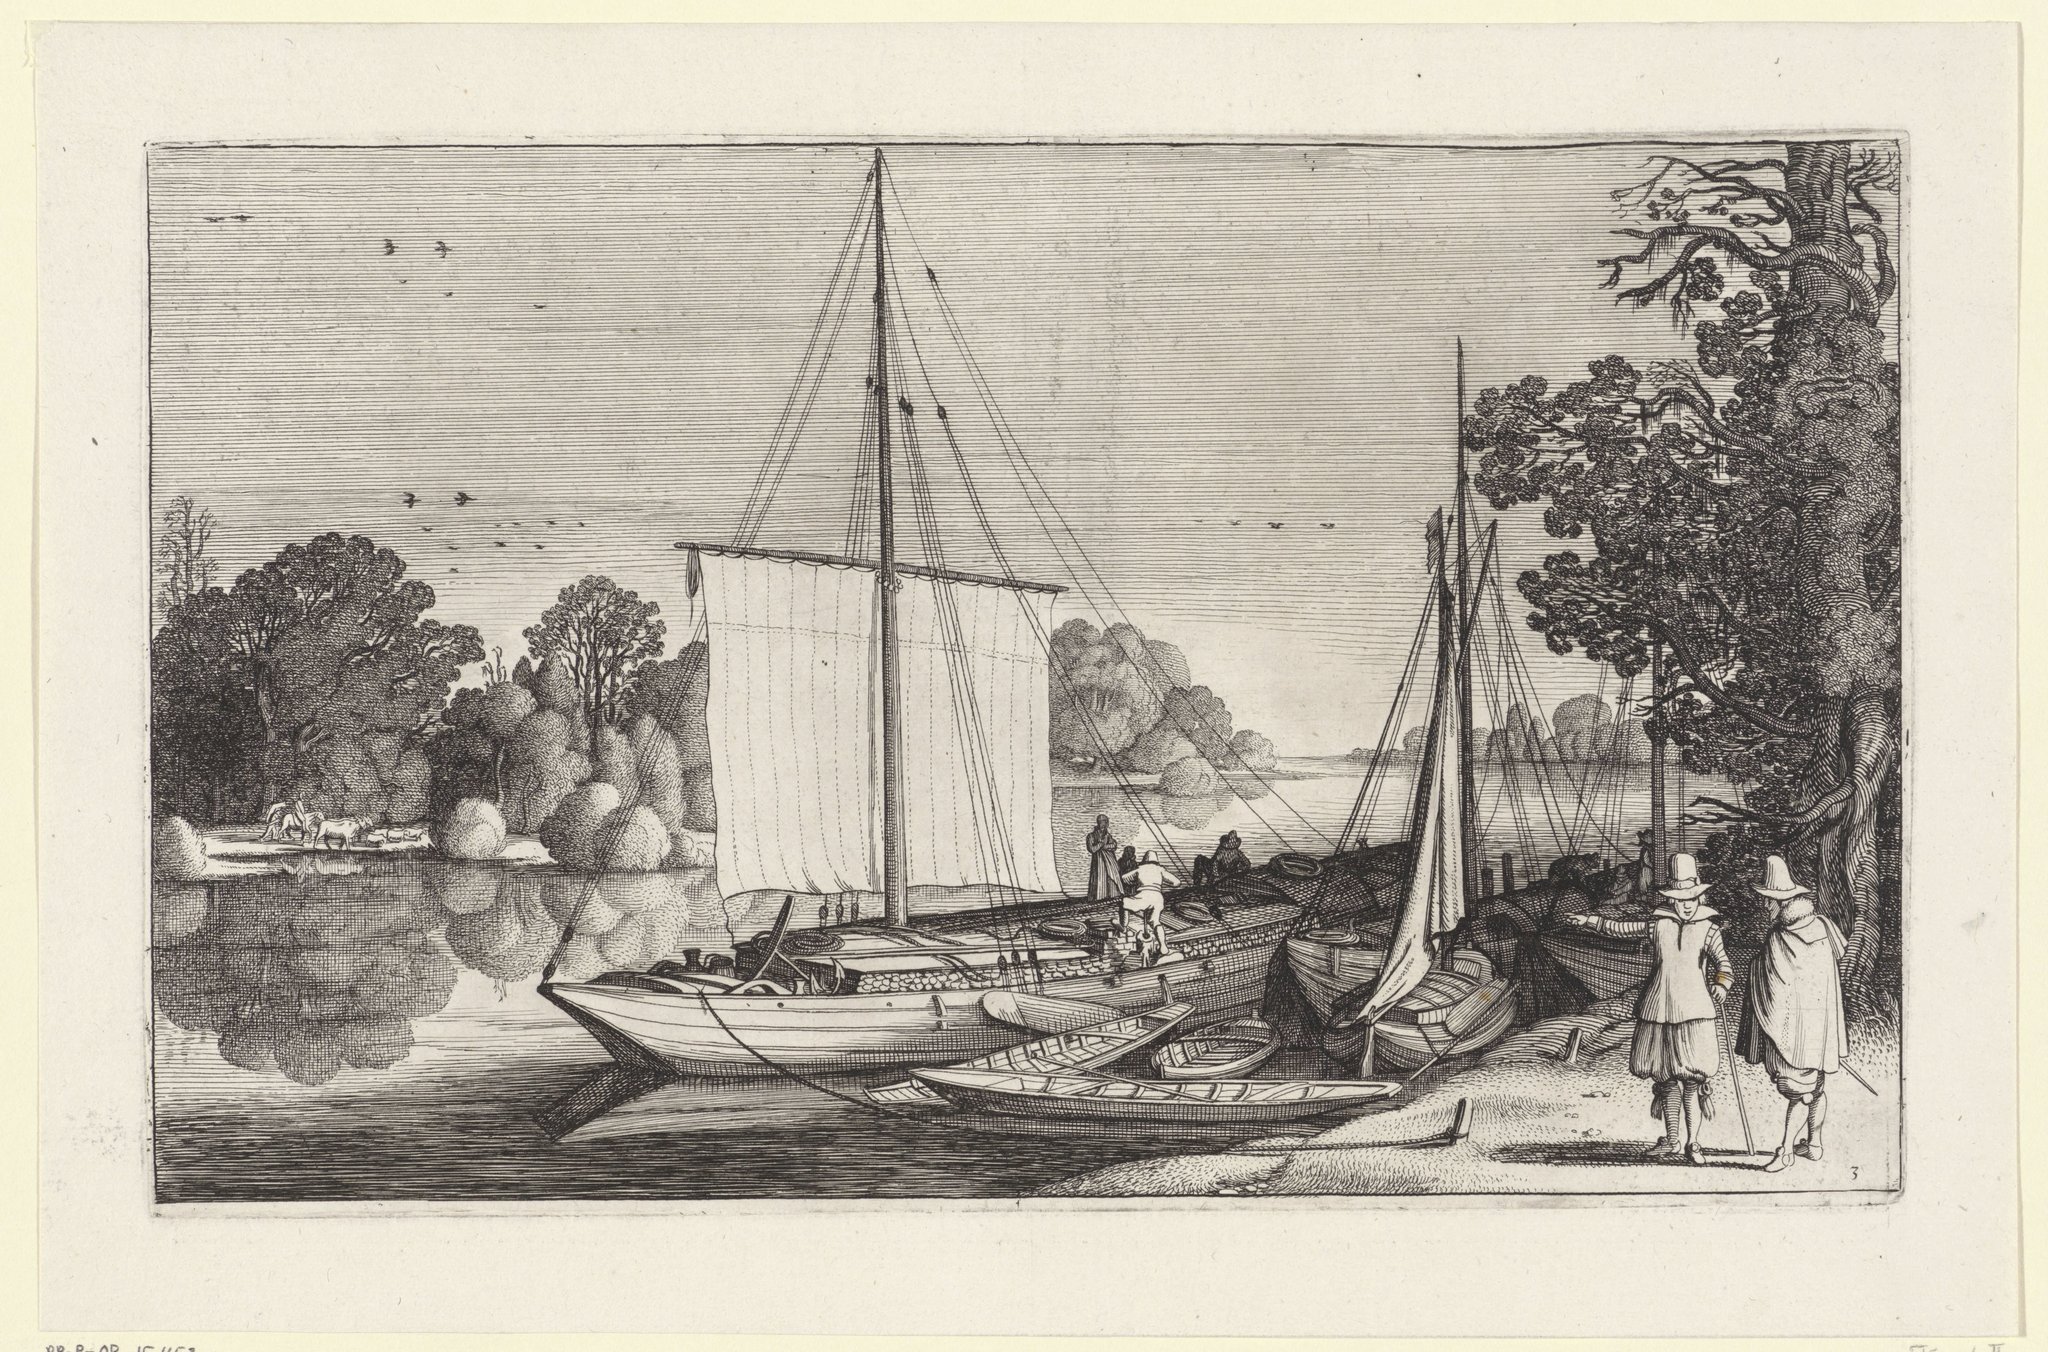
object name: print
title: Turfschepen langs een kade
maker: jan van de velde (ii)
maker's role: draughtsman, painter, print maker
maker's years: 1593-1641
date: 1603-1641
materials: paper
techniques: etching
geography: northern netherlands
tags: peat (soil type), sailing-ship, sailing-boat, river, traffic and transport (+ arrival, coming to anchor, at anchor), index finger forwards, pointing, indicating, netherlands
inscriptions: collector's mark: Lugt 240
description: Twee figuren bij turfschepen langs een kade. Derde prent van een serie van vier.